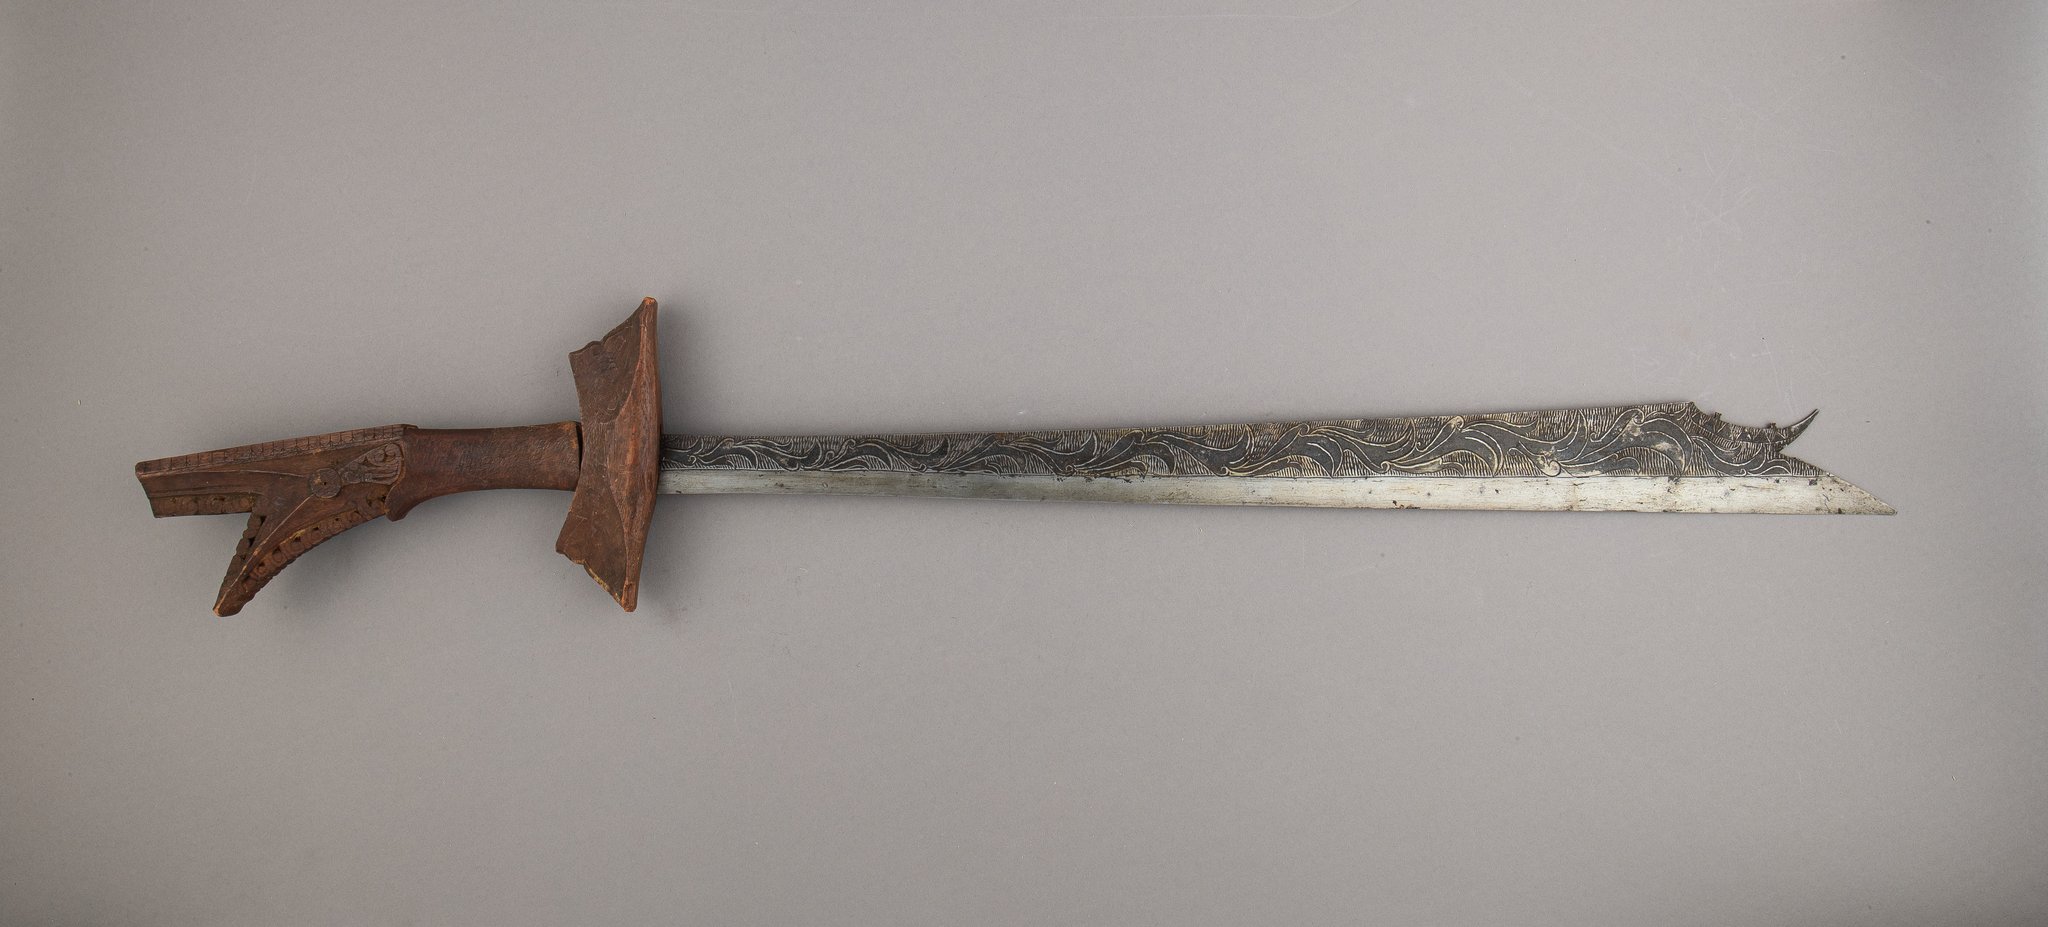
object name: sword kampilan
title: Sword (Kampilan)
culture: philippine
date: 1701-1900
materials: steel, wood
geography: philippines